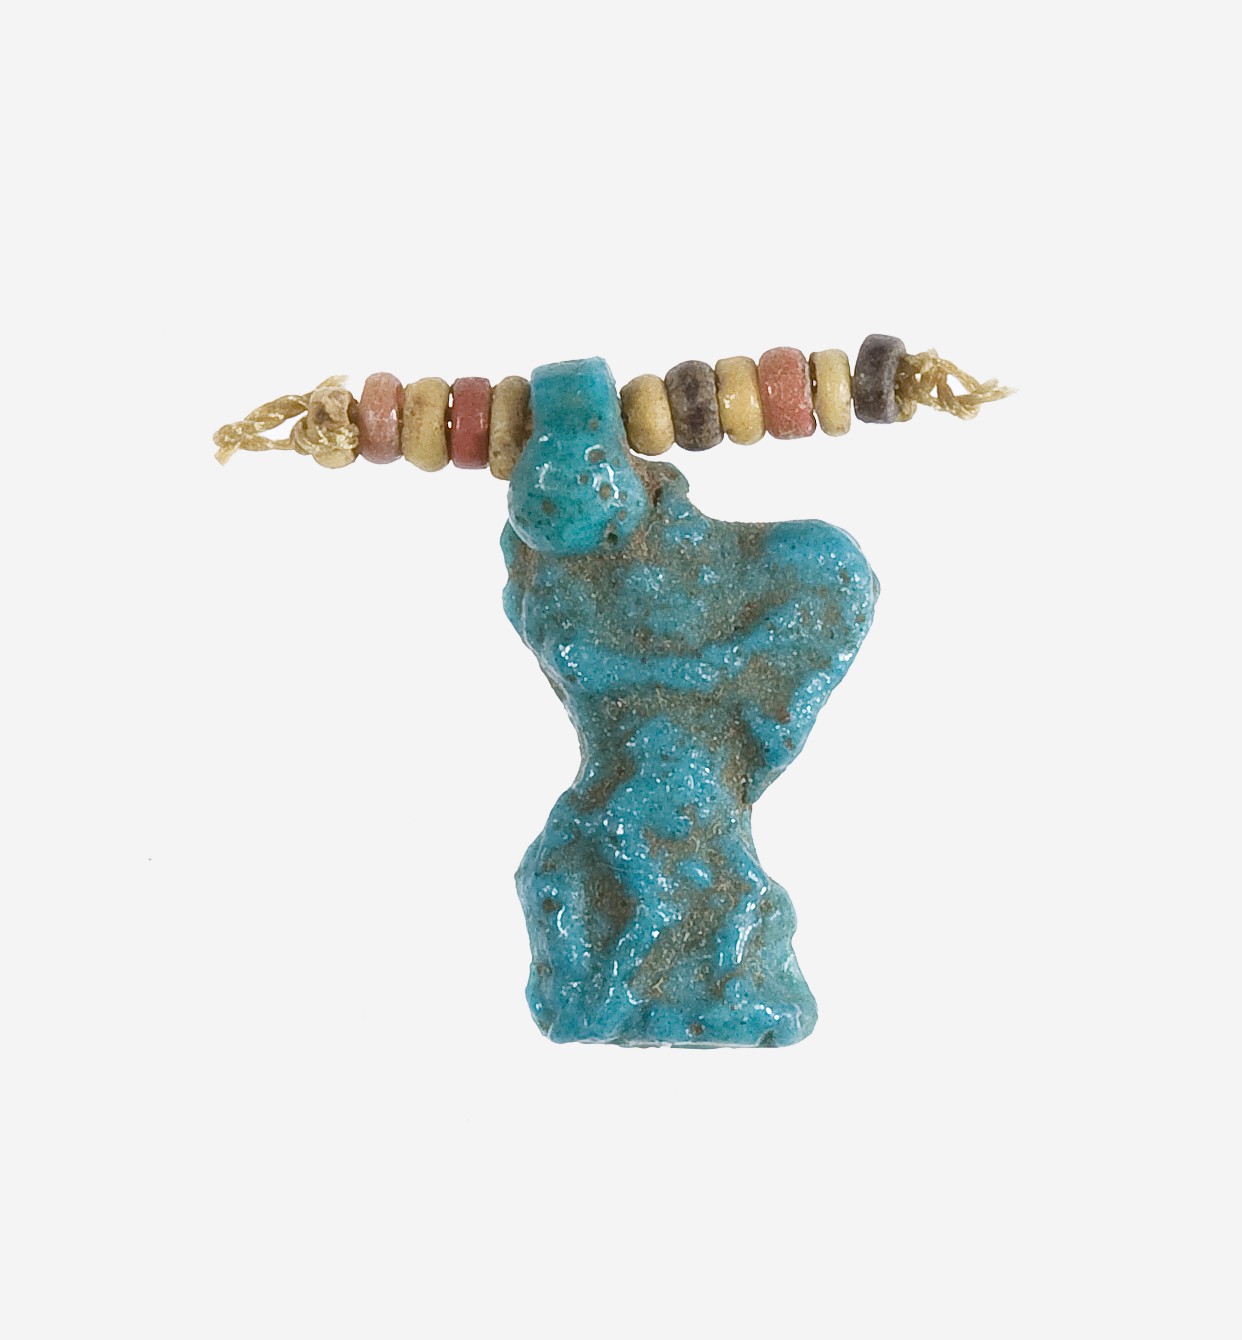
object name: pendant, be, tambourine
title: Amulet of Bes with a Tambourine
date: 1390-1352 BCE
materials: faience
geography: egypt